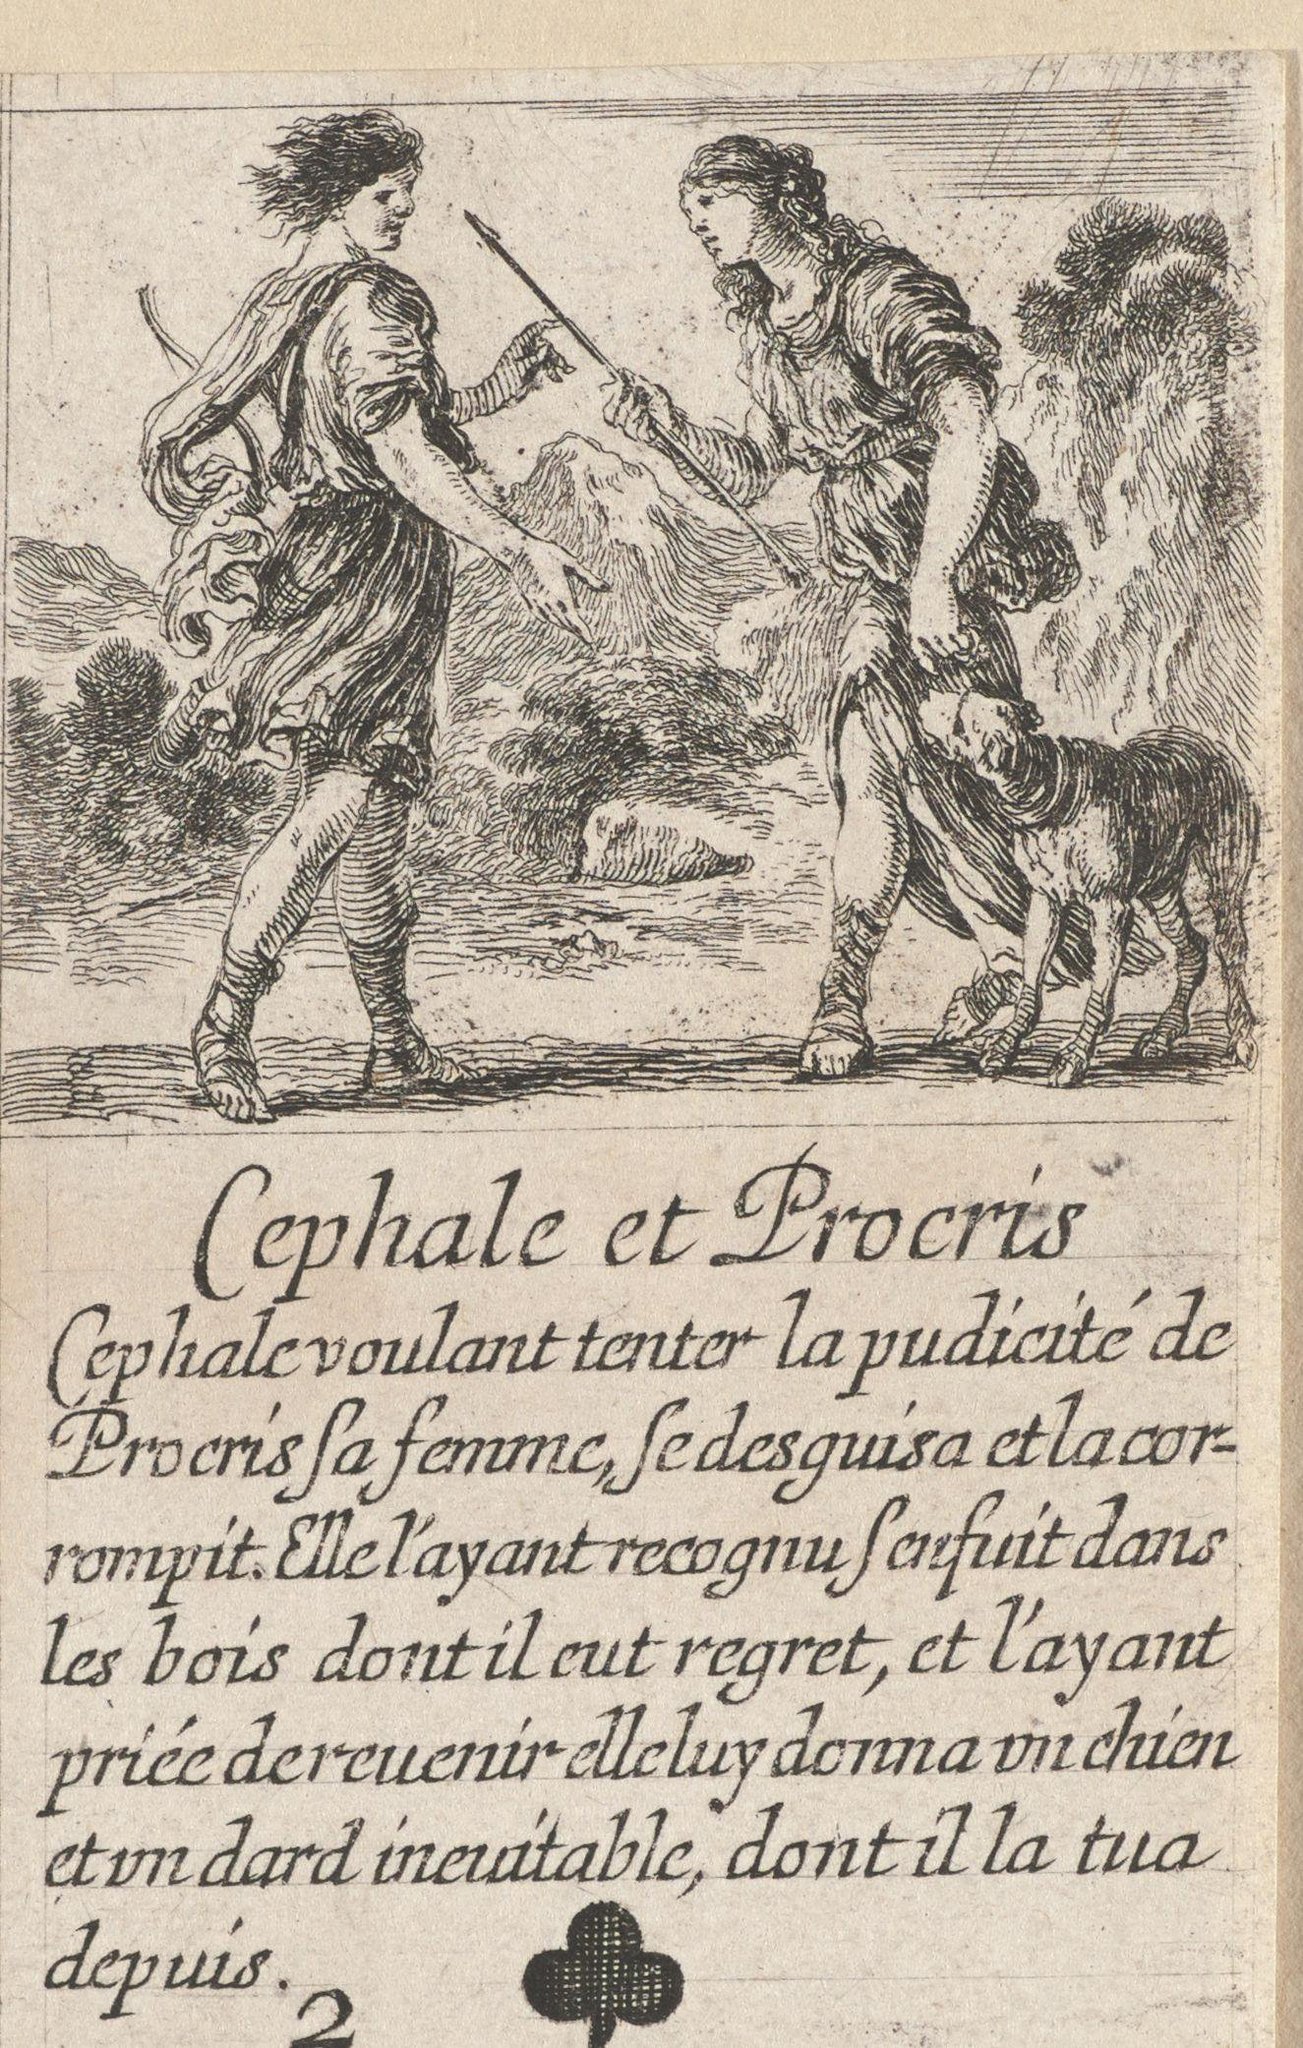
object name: playing card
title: Cephale et Procris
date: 1620-1664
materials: paper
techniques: etching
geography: france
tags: cephalus and procris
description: Deze prent maakt deel uit van een kaartspel met 52 kaarten met voorstellingen uit de Metamorfosen van Ovidius. De serie is uitgedacht door Jean Desmarests de Saint-Sorlin in opdracht van Kardinaal Mazarin. Het kaartspel werd gemaakt voor de jonge Lodewijk XIV, samen met het Jeu des Reynes Renommées, Jeu de la Géographie en Jeu des Rois de France.